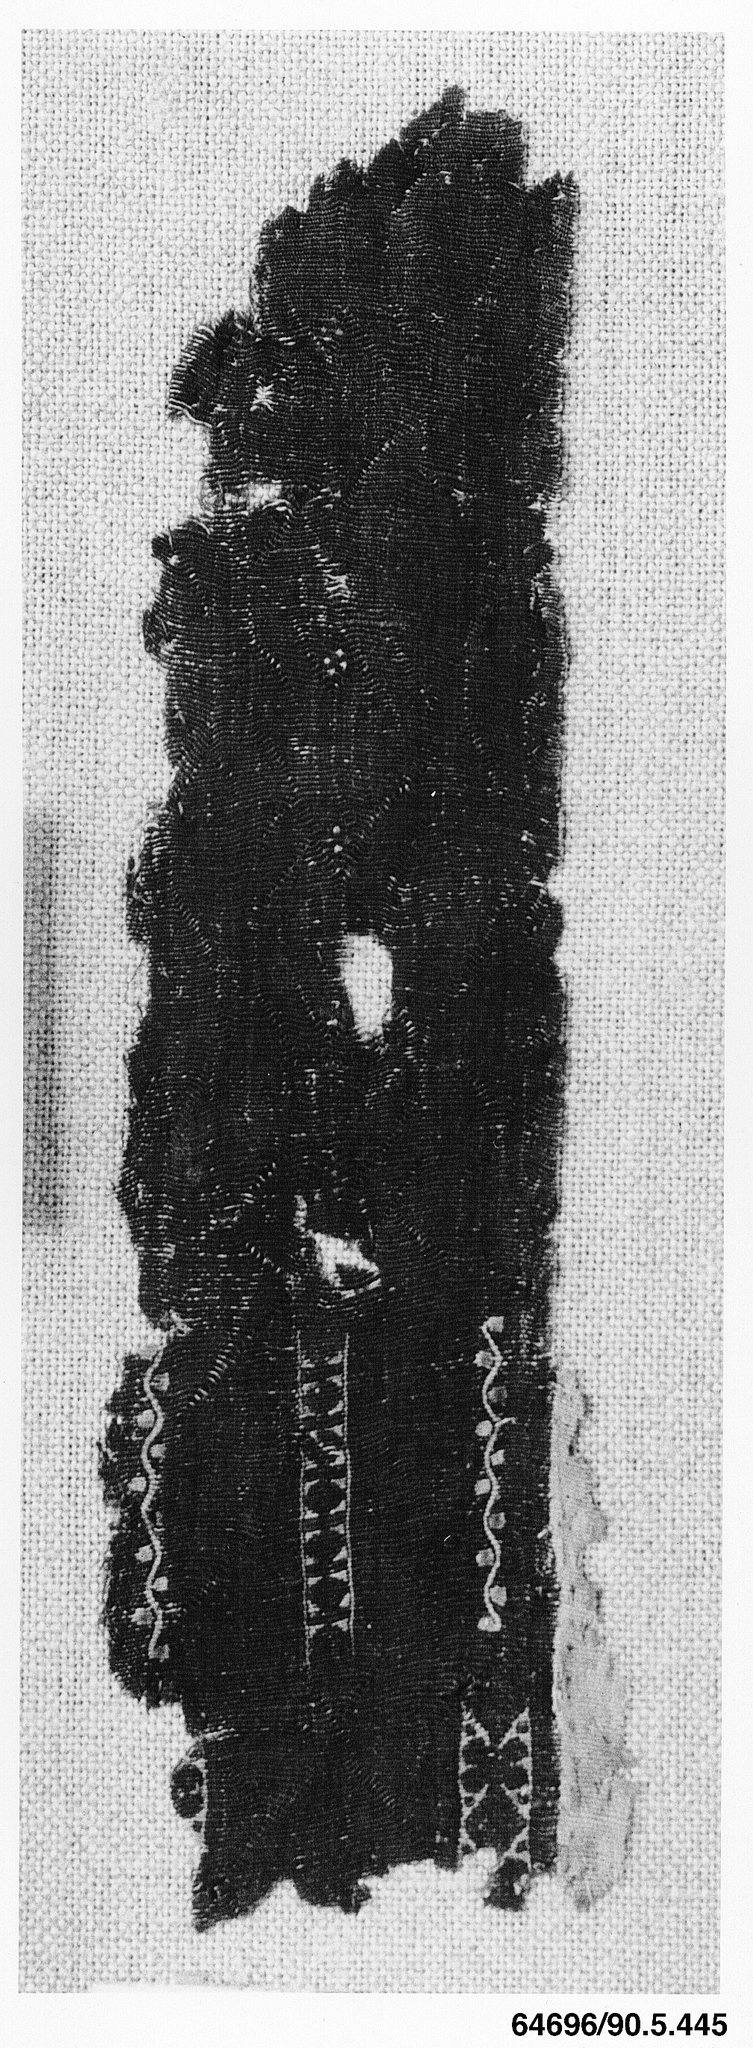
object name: textile fragment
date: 201-400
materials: linen, wool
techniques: weave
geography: egypt